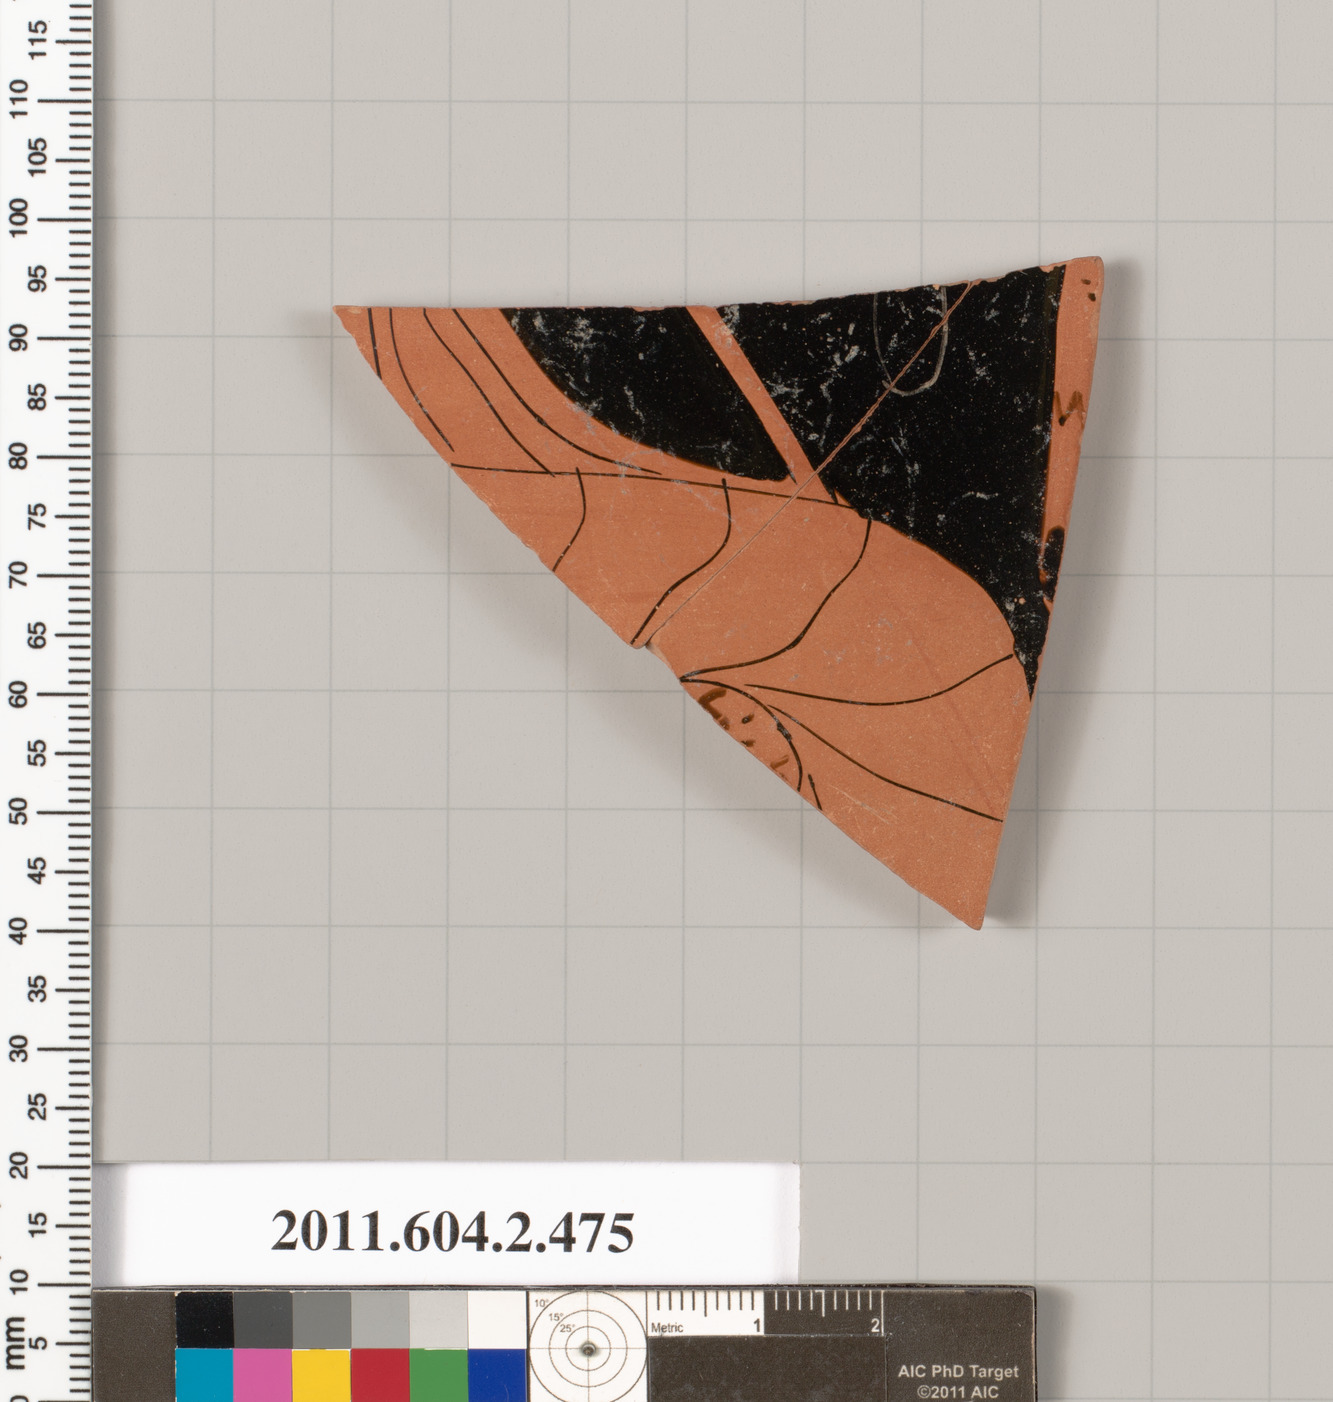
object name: column krater fragment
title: Terracotta fragment of a column-krater (bowl for mixing wine and water)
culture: greek, attic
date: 460-440 BCE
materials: terracotta